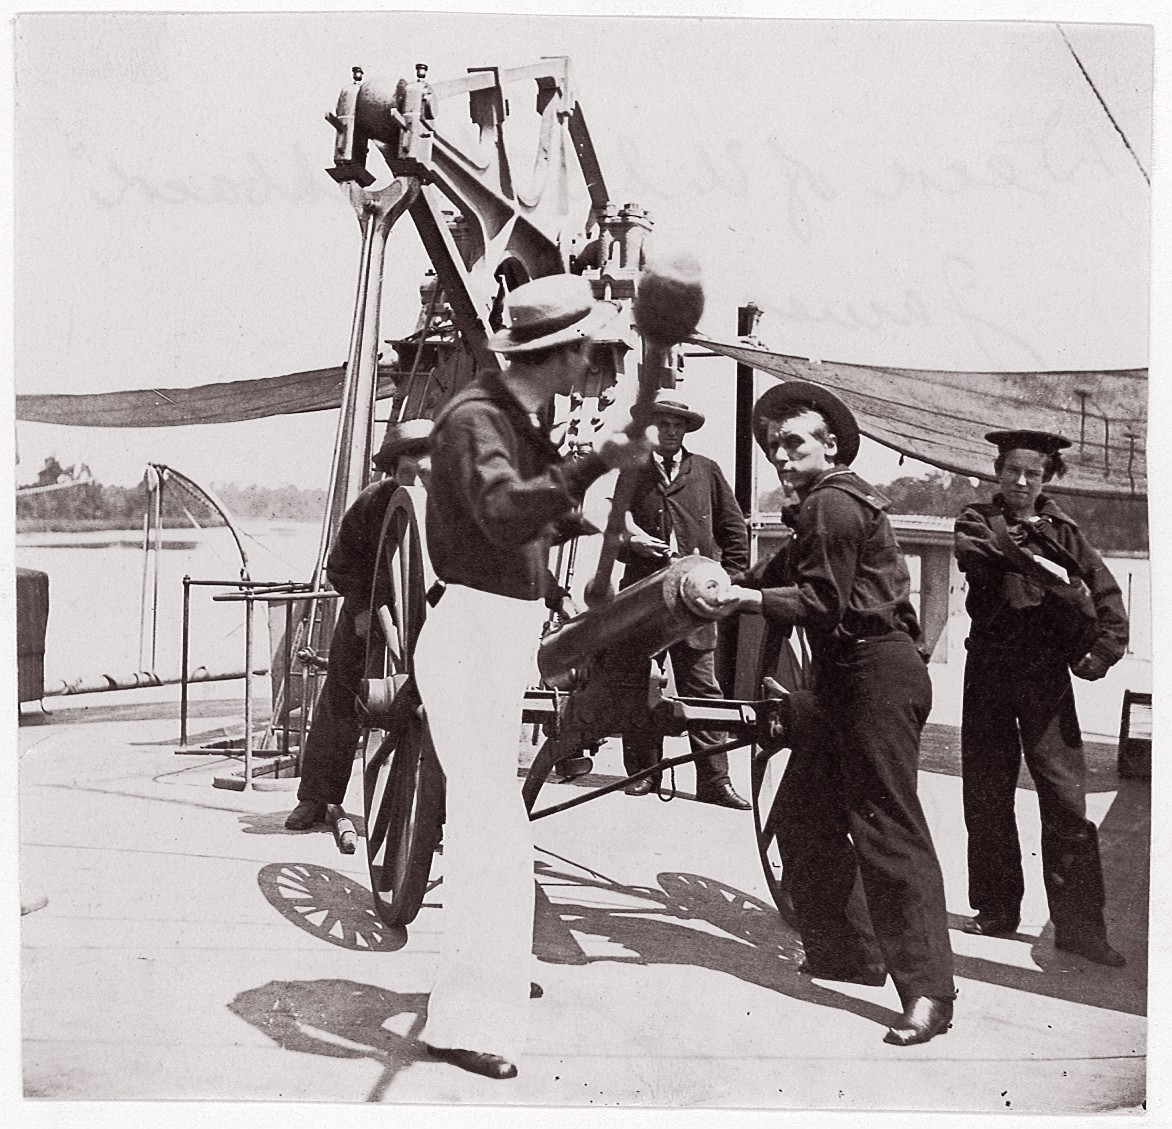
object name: photograph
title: Officers of U.S.S. Hunchback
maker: Anonymous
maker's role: artist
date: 1861-1865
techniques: albumen silver print, glass negative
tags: soldiers,cannons,american civil war